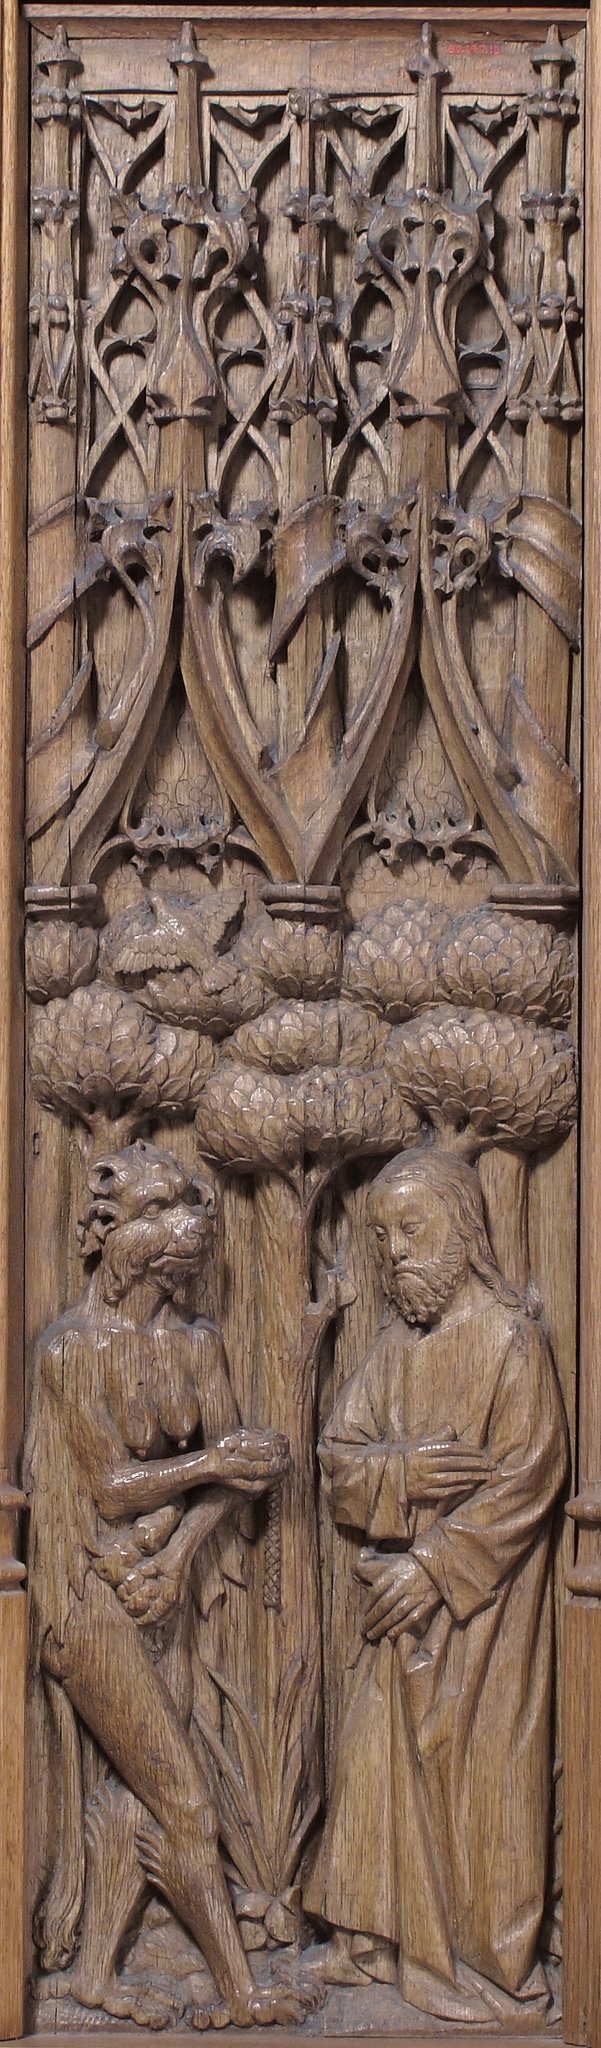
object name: panel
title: Panel with the Temptation of Christ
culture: french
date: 1501-1533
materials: wood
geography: france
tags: christ